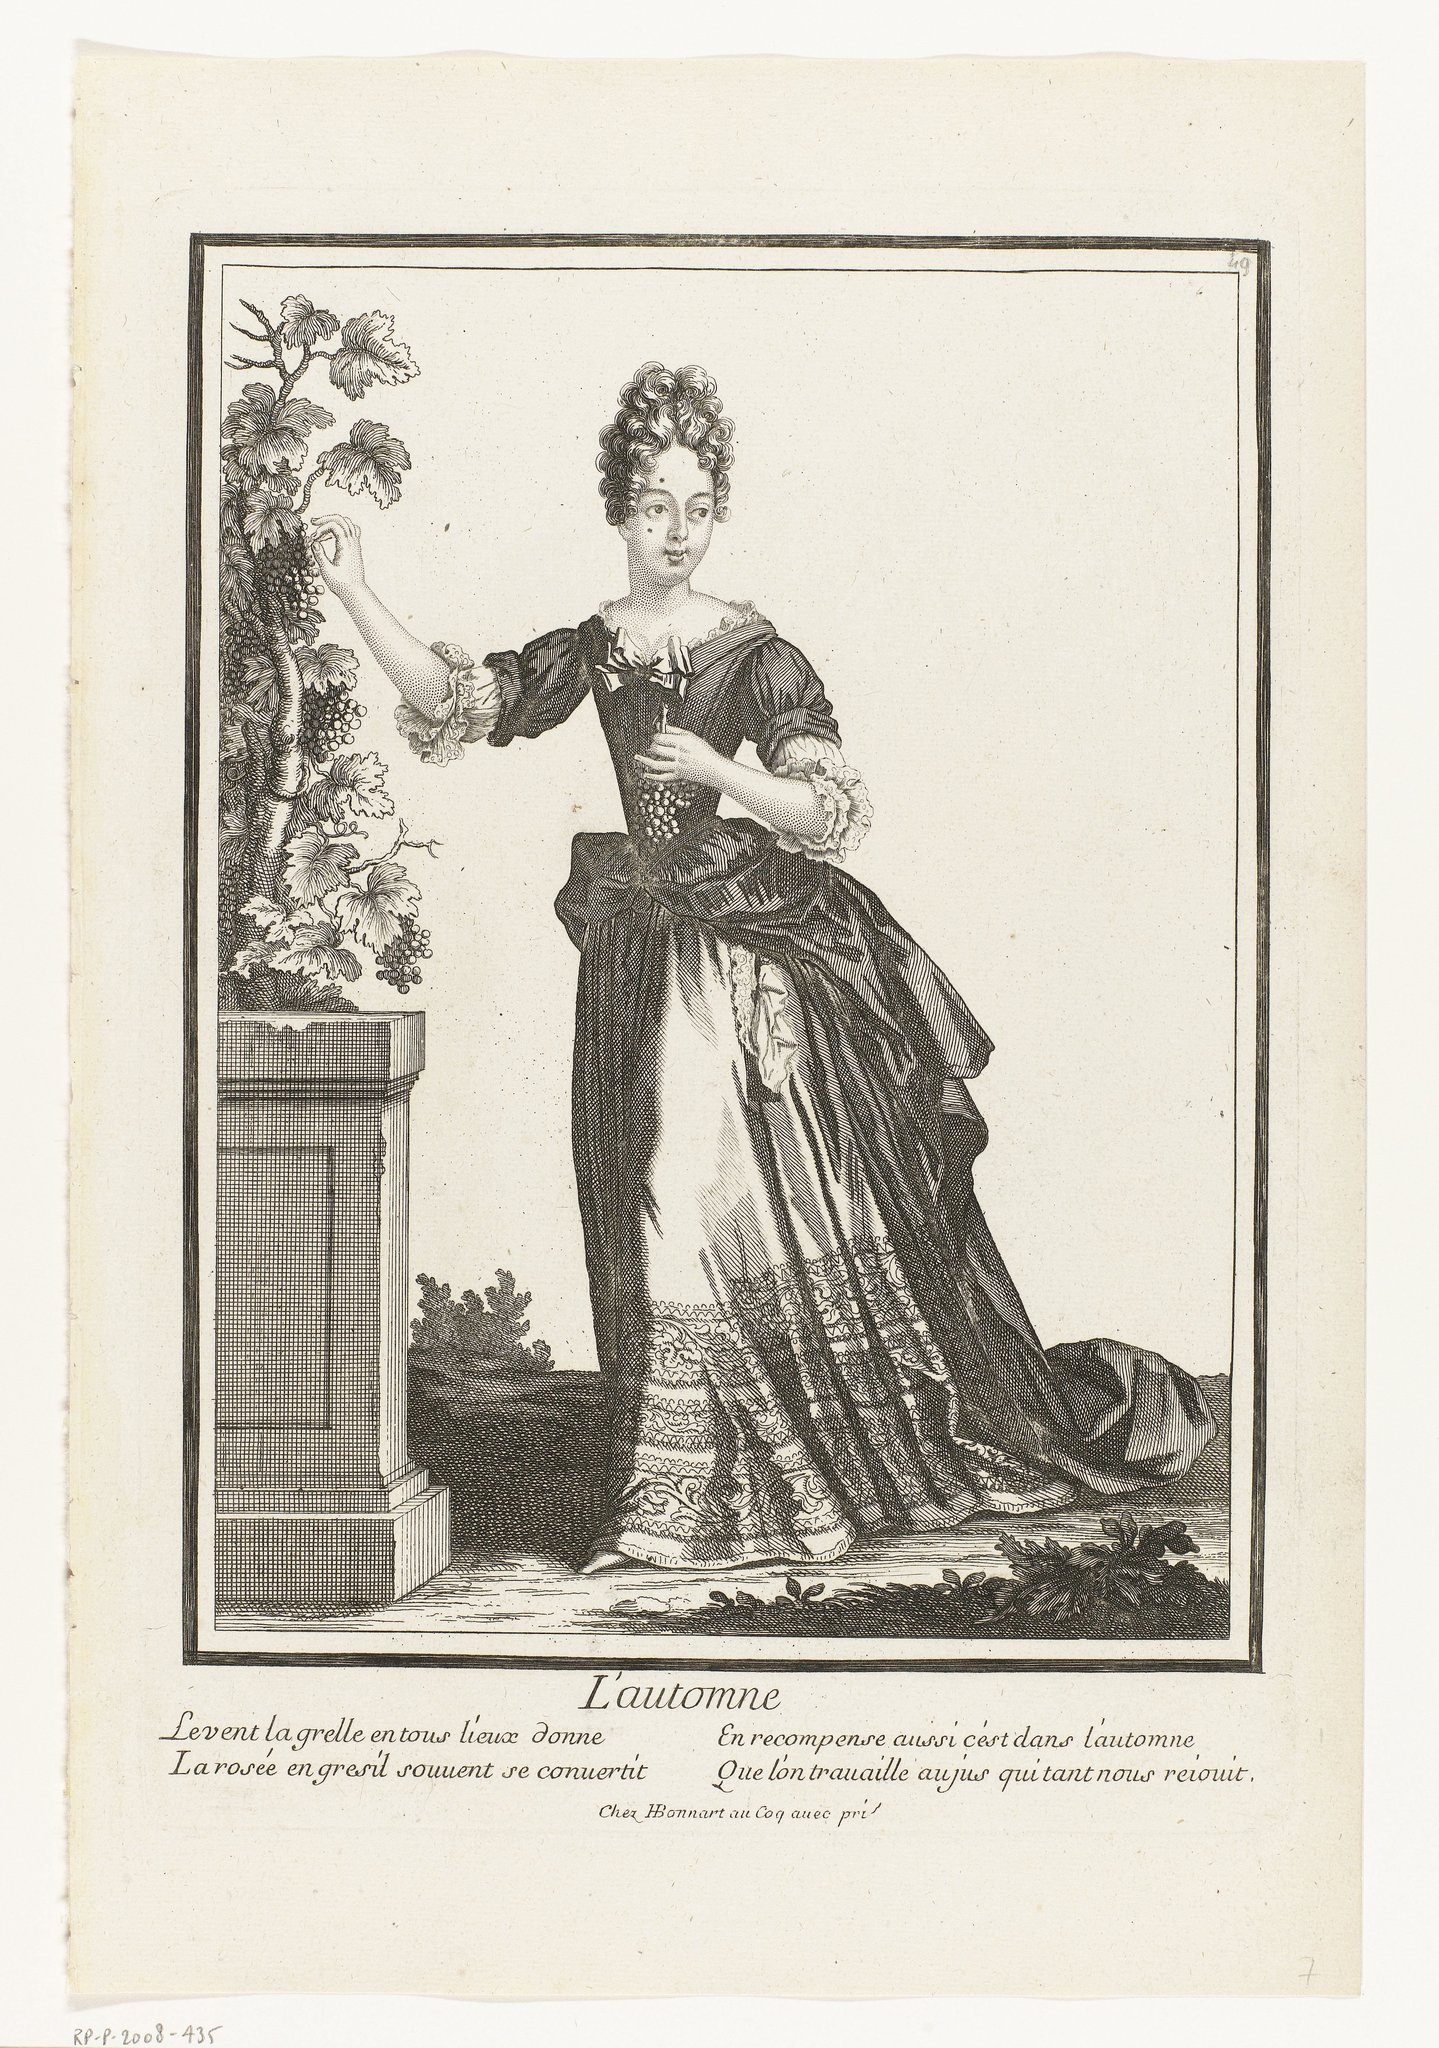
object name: print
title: L'Automne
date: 1652-1711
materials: paper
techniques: engraving, etching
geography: france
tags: year divided into four seasons, vintage, grape harvest, autumn, fall, 'autumnus'; 'autunno' (ripa), bunch of grapes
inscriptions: collector's mark: Lugt 2760, collector's mark: Lugt 2228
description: Maakt deel uit van een vierdelige serie met personificaties van de vier seizoenen.